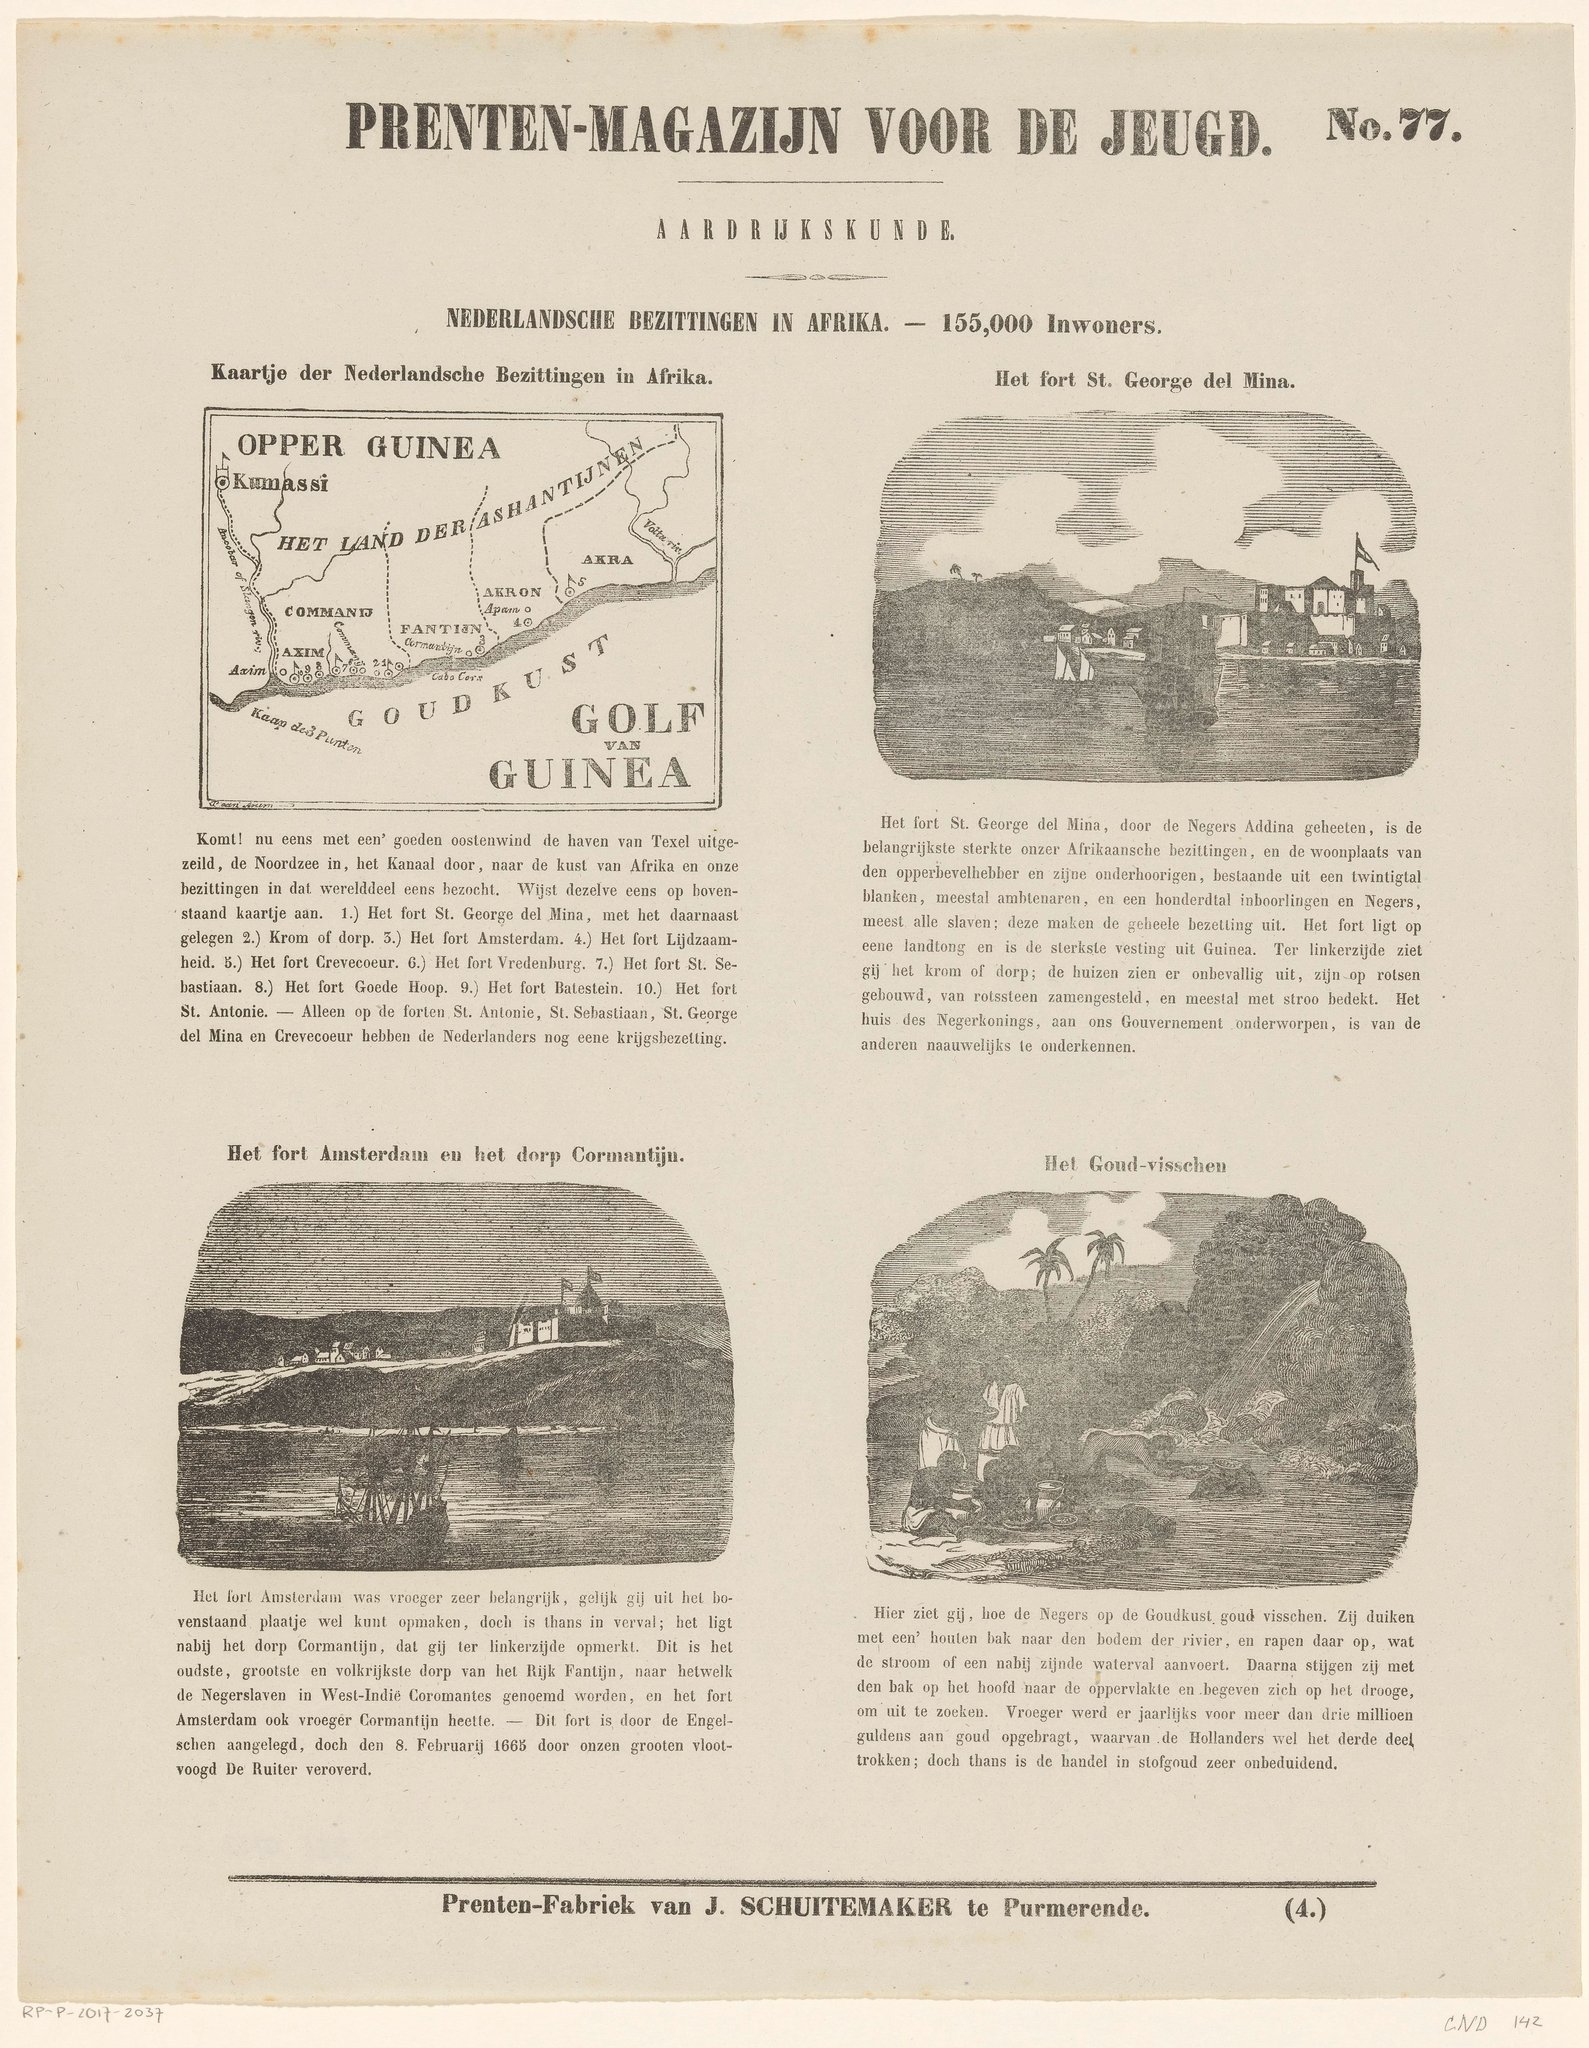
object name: popular print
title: Nederlandsche bezittingen in Afrika. - 155,000 inwoners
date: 1850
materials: paper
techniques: letterpress printing, engraving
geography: netherlands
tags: colonial system, (map of) africa, ford, maps, atlases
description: Blad met 4 voorstellingen van Nederlandse bezittingen in Afrika. Een kaart en voorstellingen van belangrijke gebouwen, zoals het Fort St. Jorge del Mina en het Fort Amsterdam. Boven elke voorstelling een titel en onder elke voorstelling een vierregelig vers. Genummerd rechtsboven: No. 77, genummerd rechtsonder: (4.).